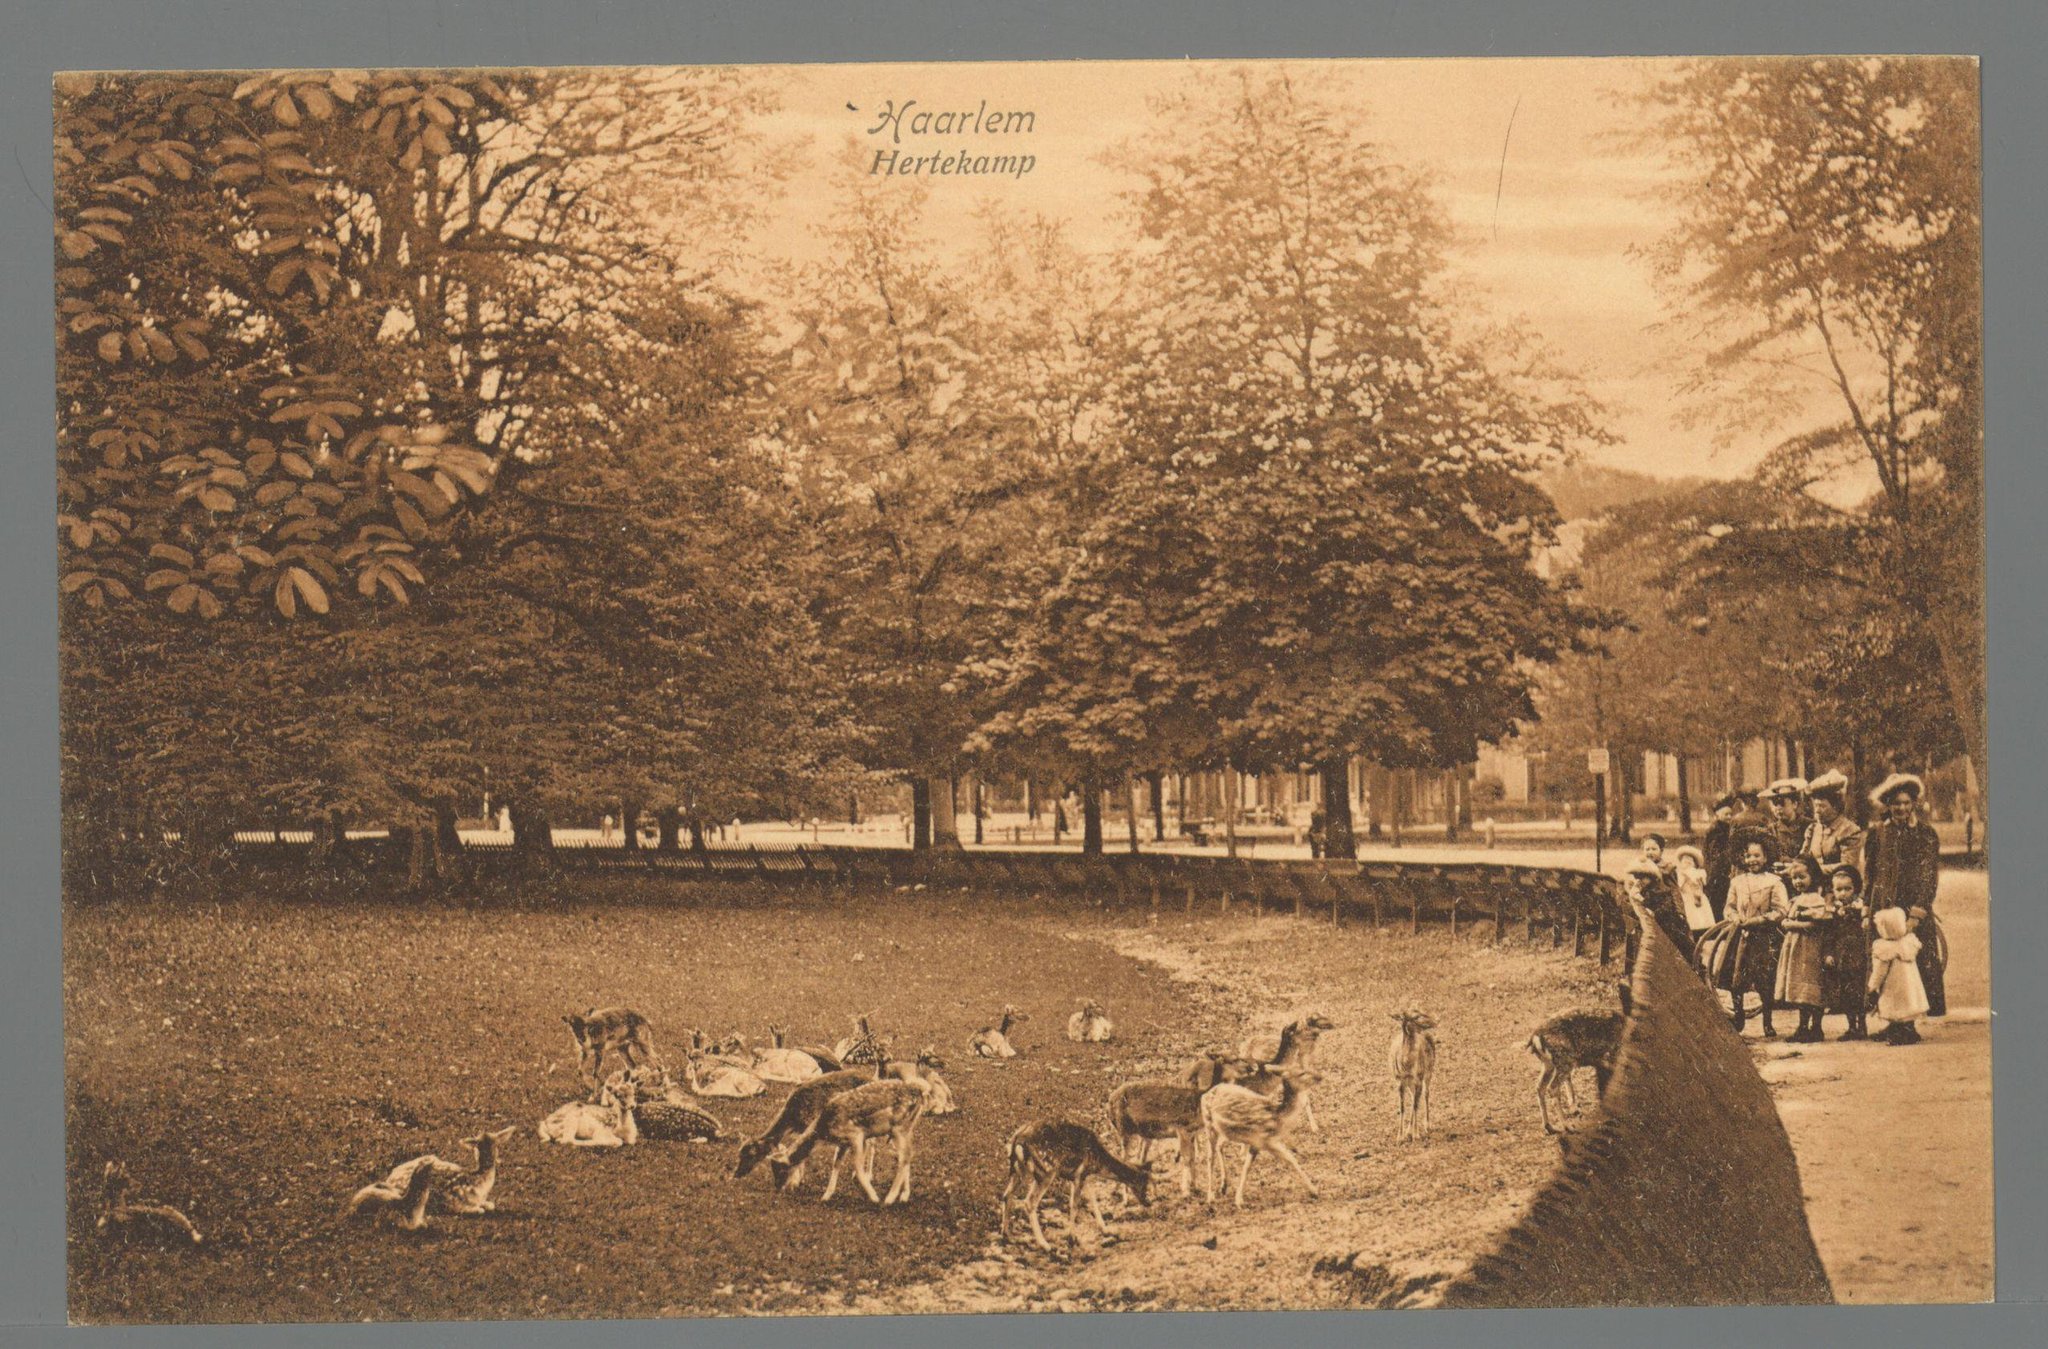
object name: ansichtkaart, prentbriefkaart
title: Haarlem. Hertekamp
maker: Anonymous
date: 1911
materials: cardboard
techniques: photograph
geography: leipzig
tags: hoofed animals: deer, haarlem